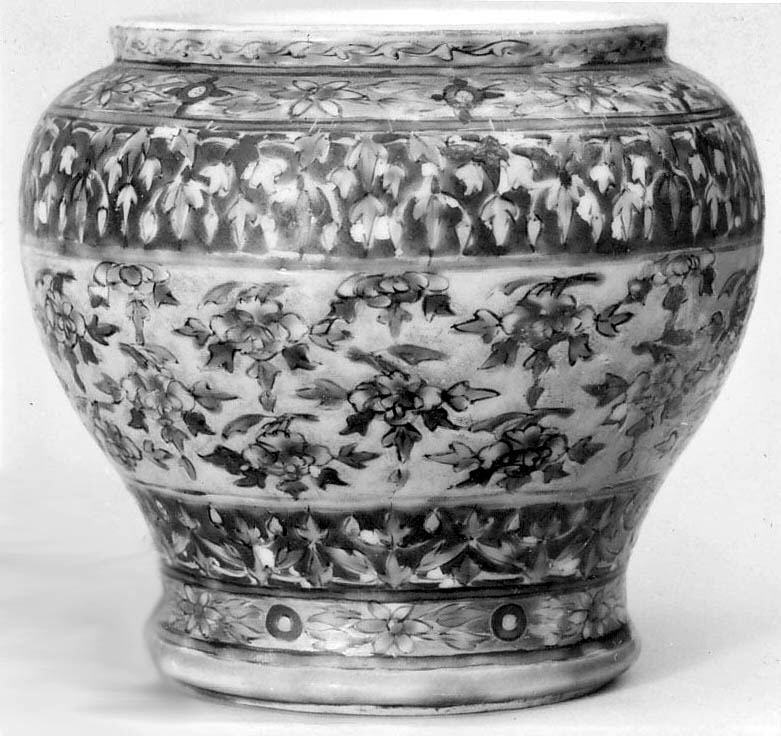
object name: jar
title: Jar with floral pattern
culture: chinese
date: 1801-1900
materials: enamel, porcelain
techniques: overglaze, painting, polychrome